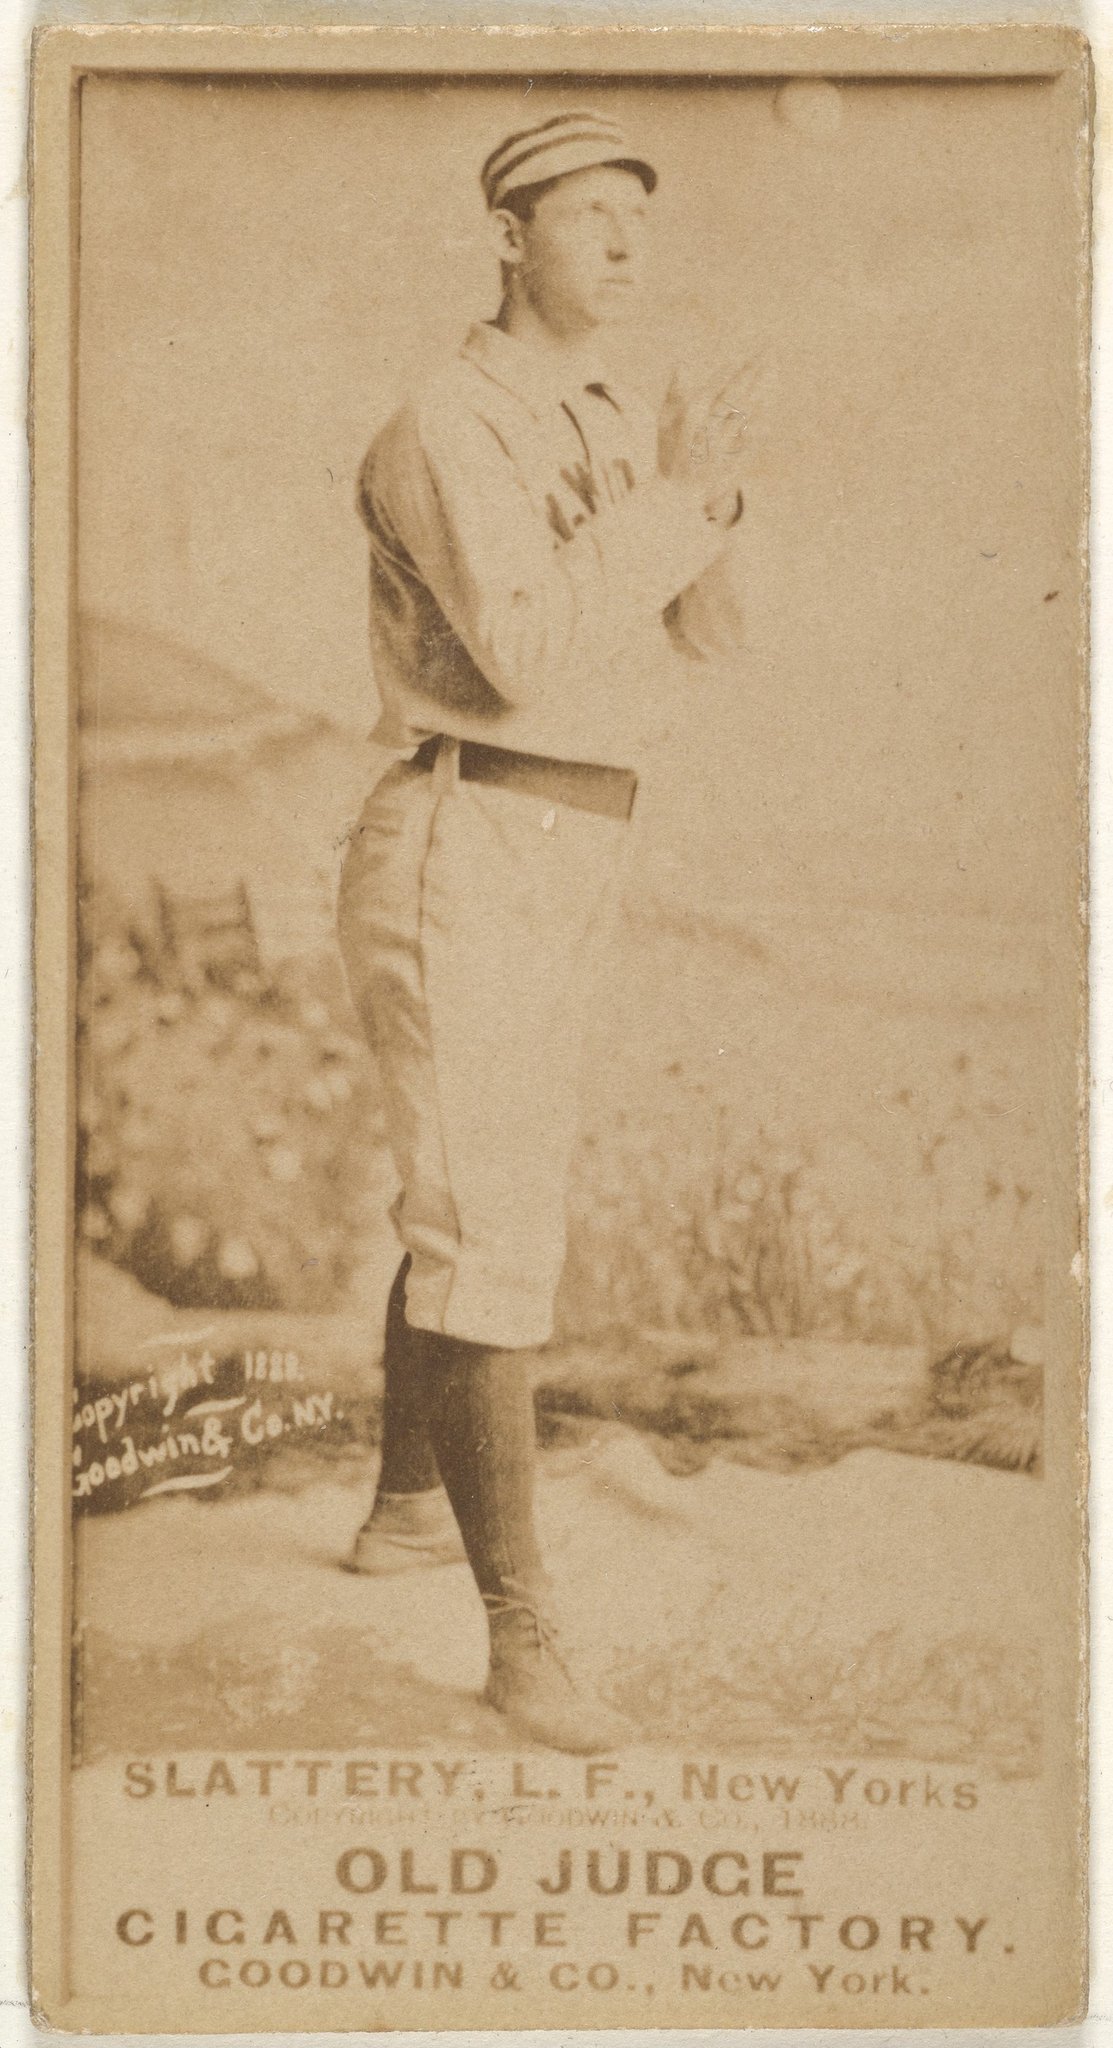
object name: baseball card, photograph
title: Michael J. Slattery, Left Field, New York, from the Old Judge series (N172) for Old Judge Cigarettes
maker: goodwin & company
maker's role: publisher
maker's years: 1850-1950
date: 1888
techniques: albumen silver print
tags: men,portraits,baseball,athletes